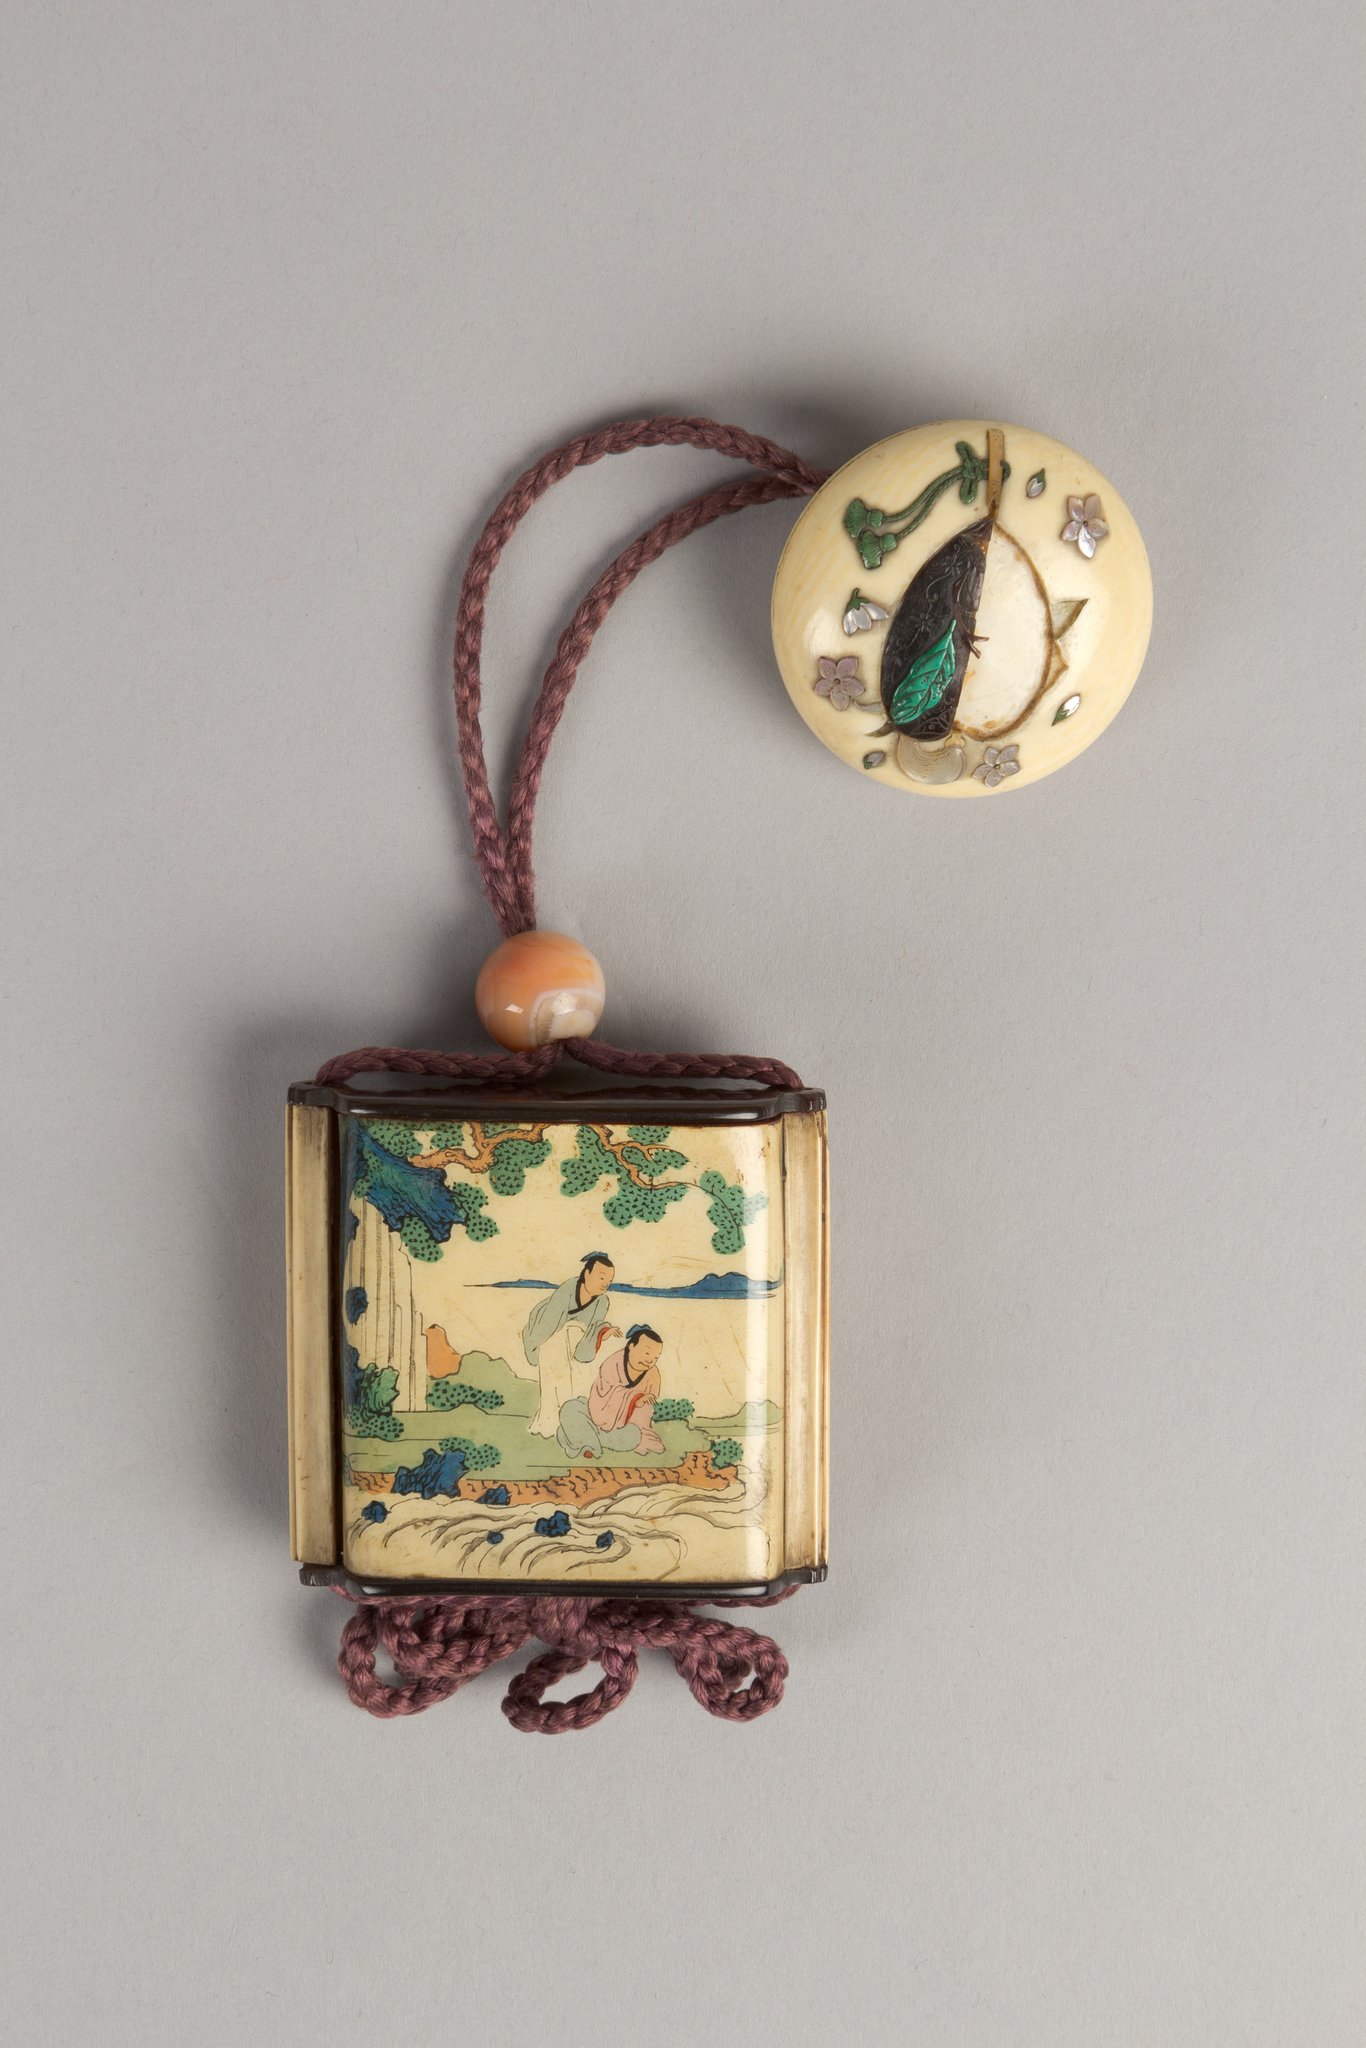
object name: inrō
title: Case (Inrō) with Design of Woman in Building Looking at a Stag (obverse); Two Men By a River with Rocks and Waterfall (reverse)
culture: japanese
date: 1801-1900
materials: wood, enamel, ivory, lacquer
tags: men,women,deer